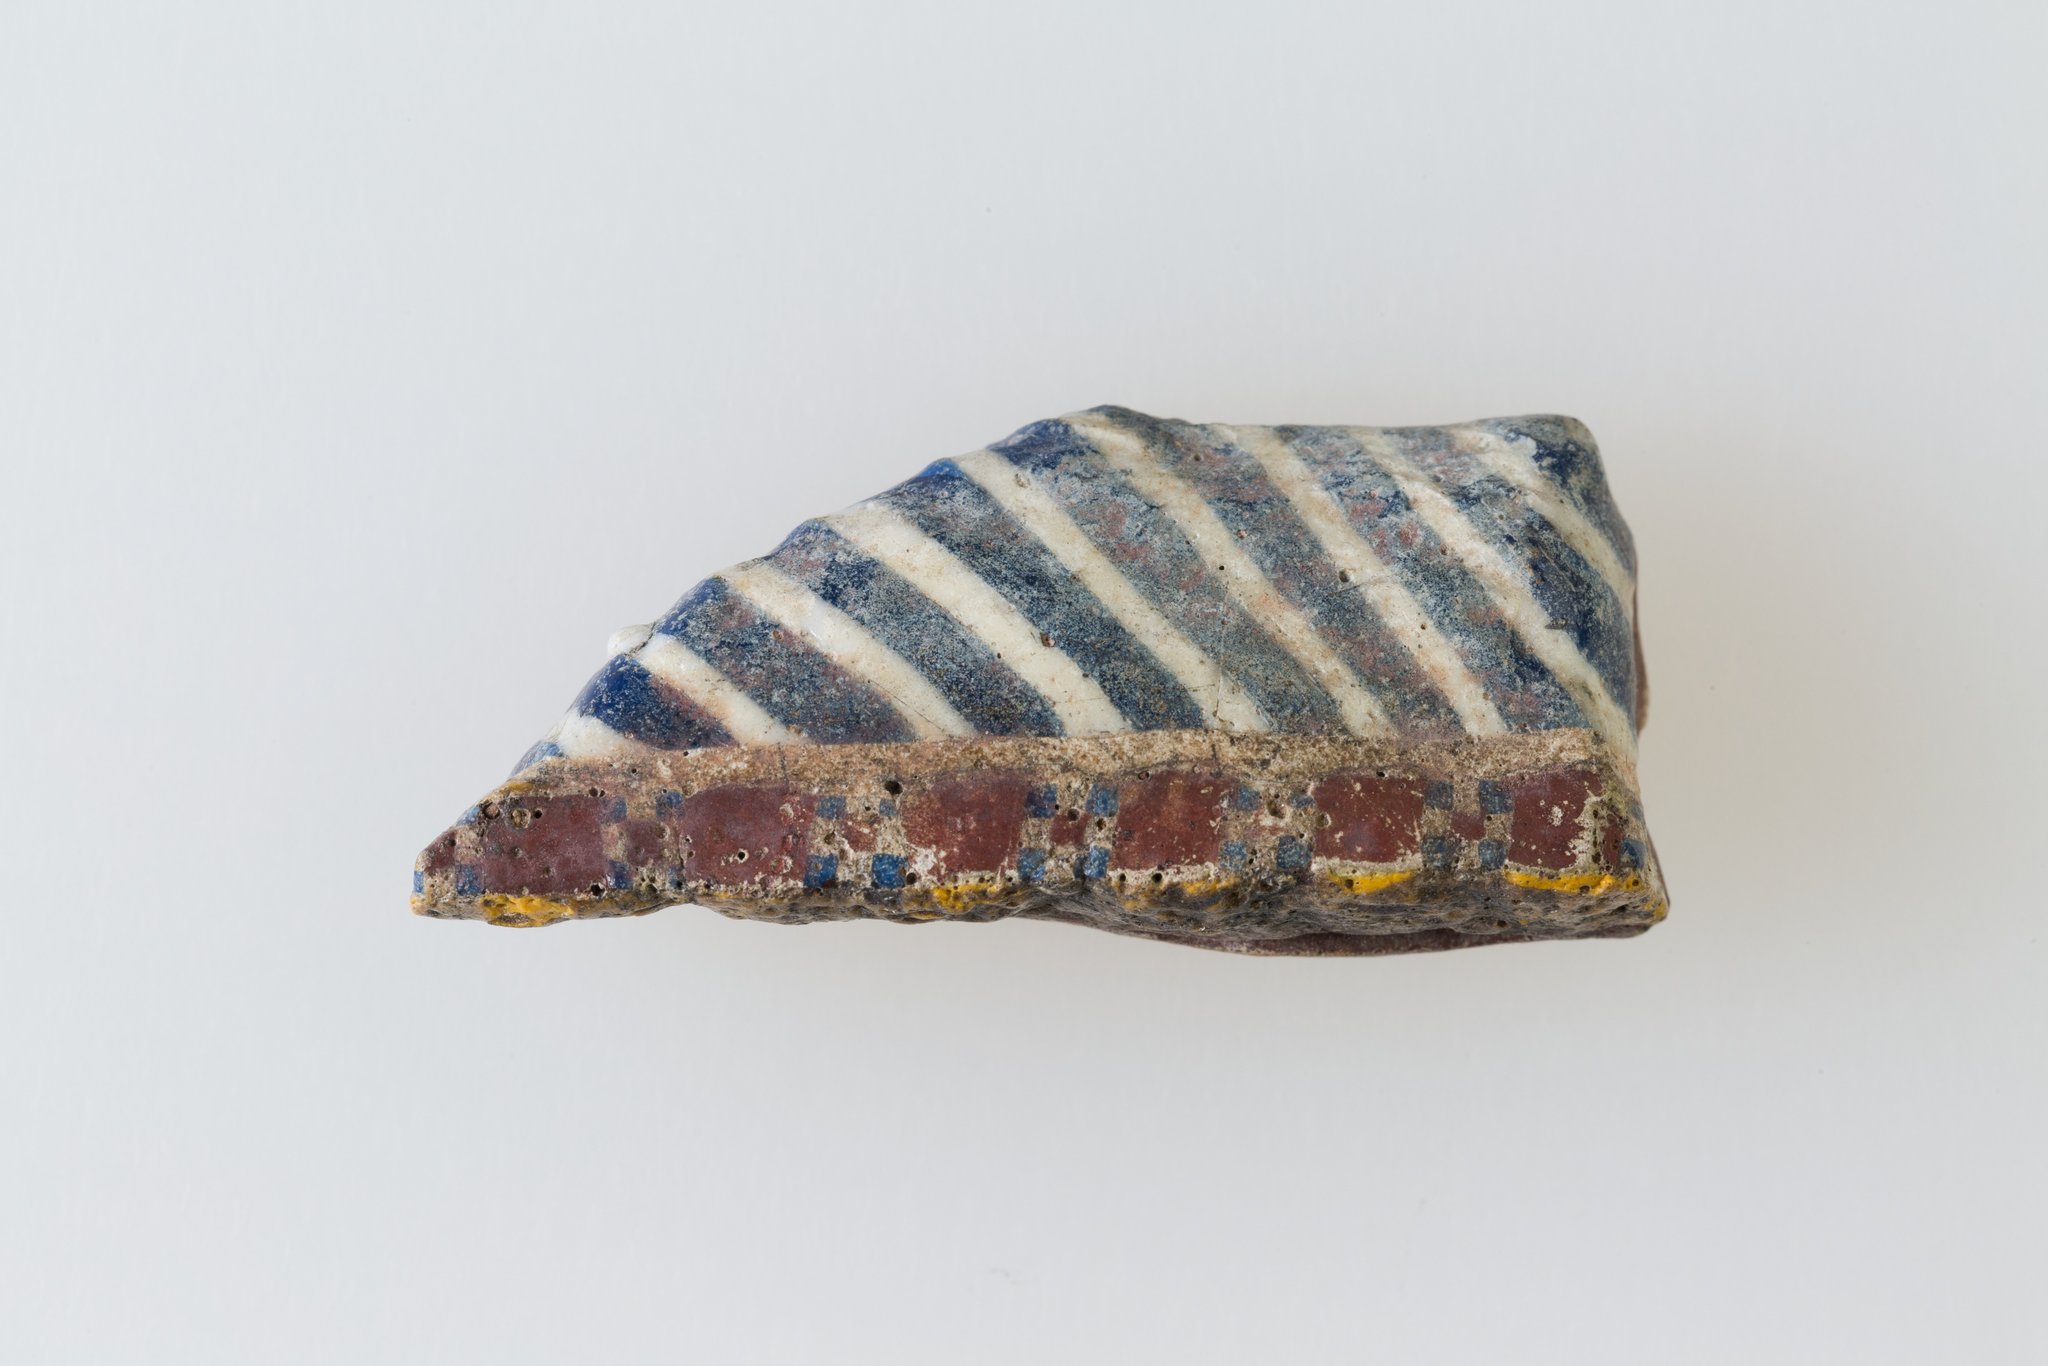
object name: inlay, stripe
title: Inlay with stripes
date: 200 BCE-100 CE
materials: glass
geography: egypt